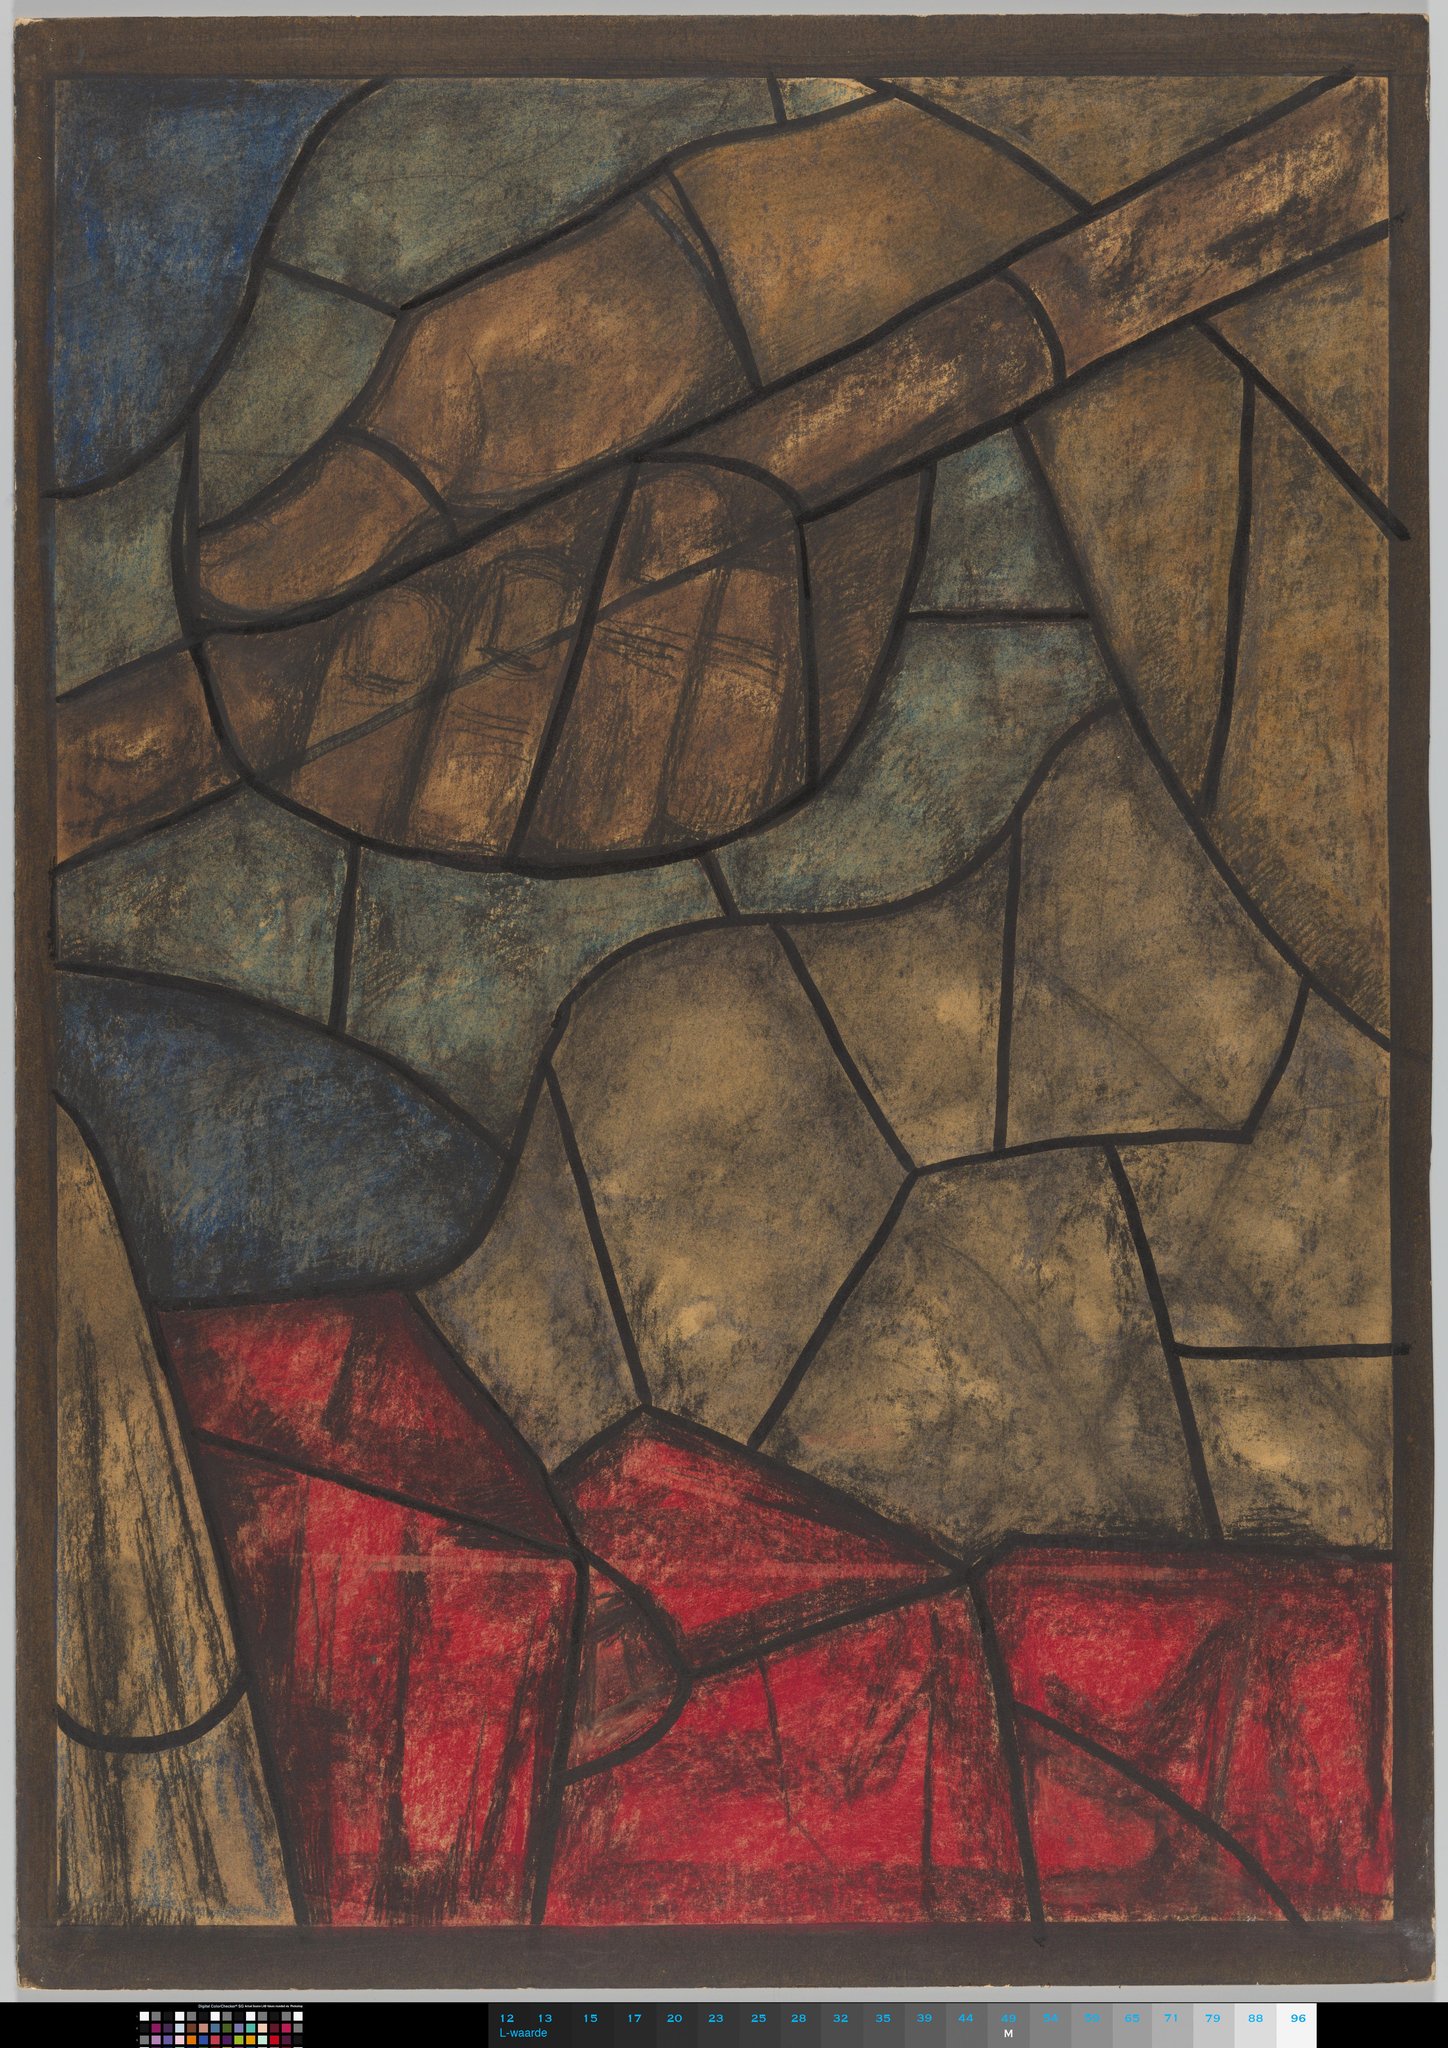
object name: drawing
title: Ontwerp voor raam in het Noordertransept in de Dom te Utrecht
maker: richard nicolaüs roland holst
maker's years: 1868-1938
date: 1934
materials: cardboard, chalk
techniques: brush